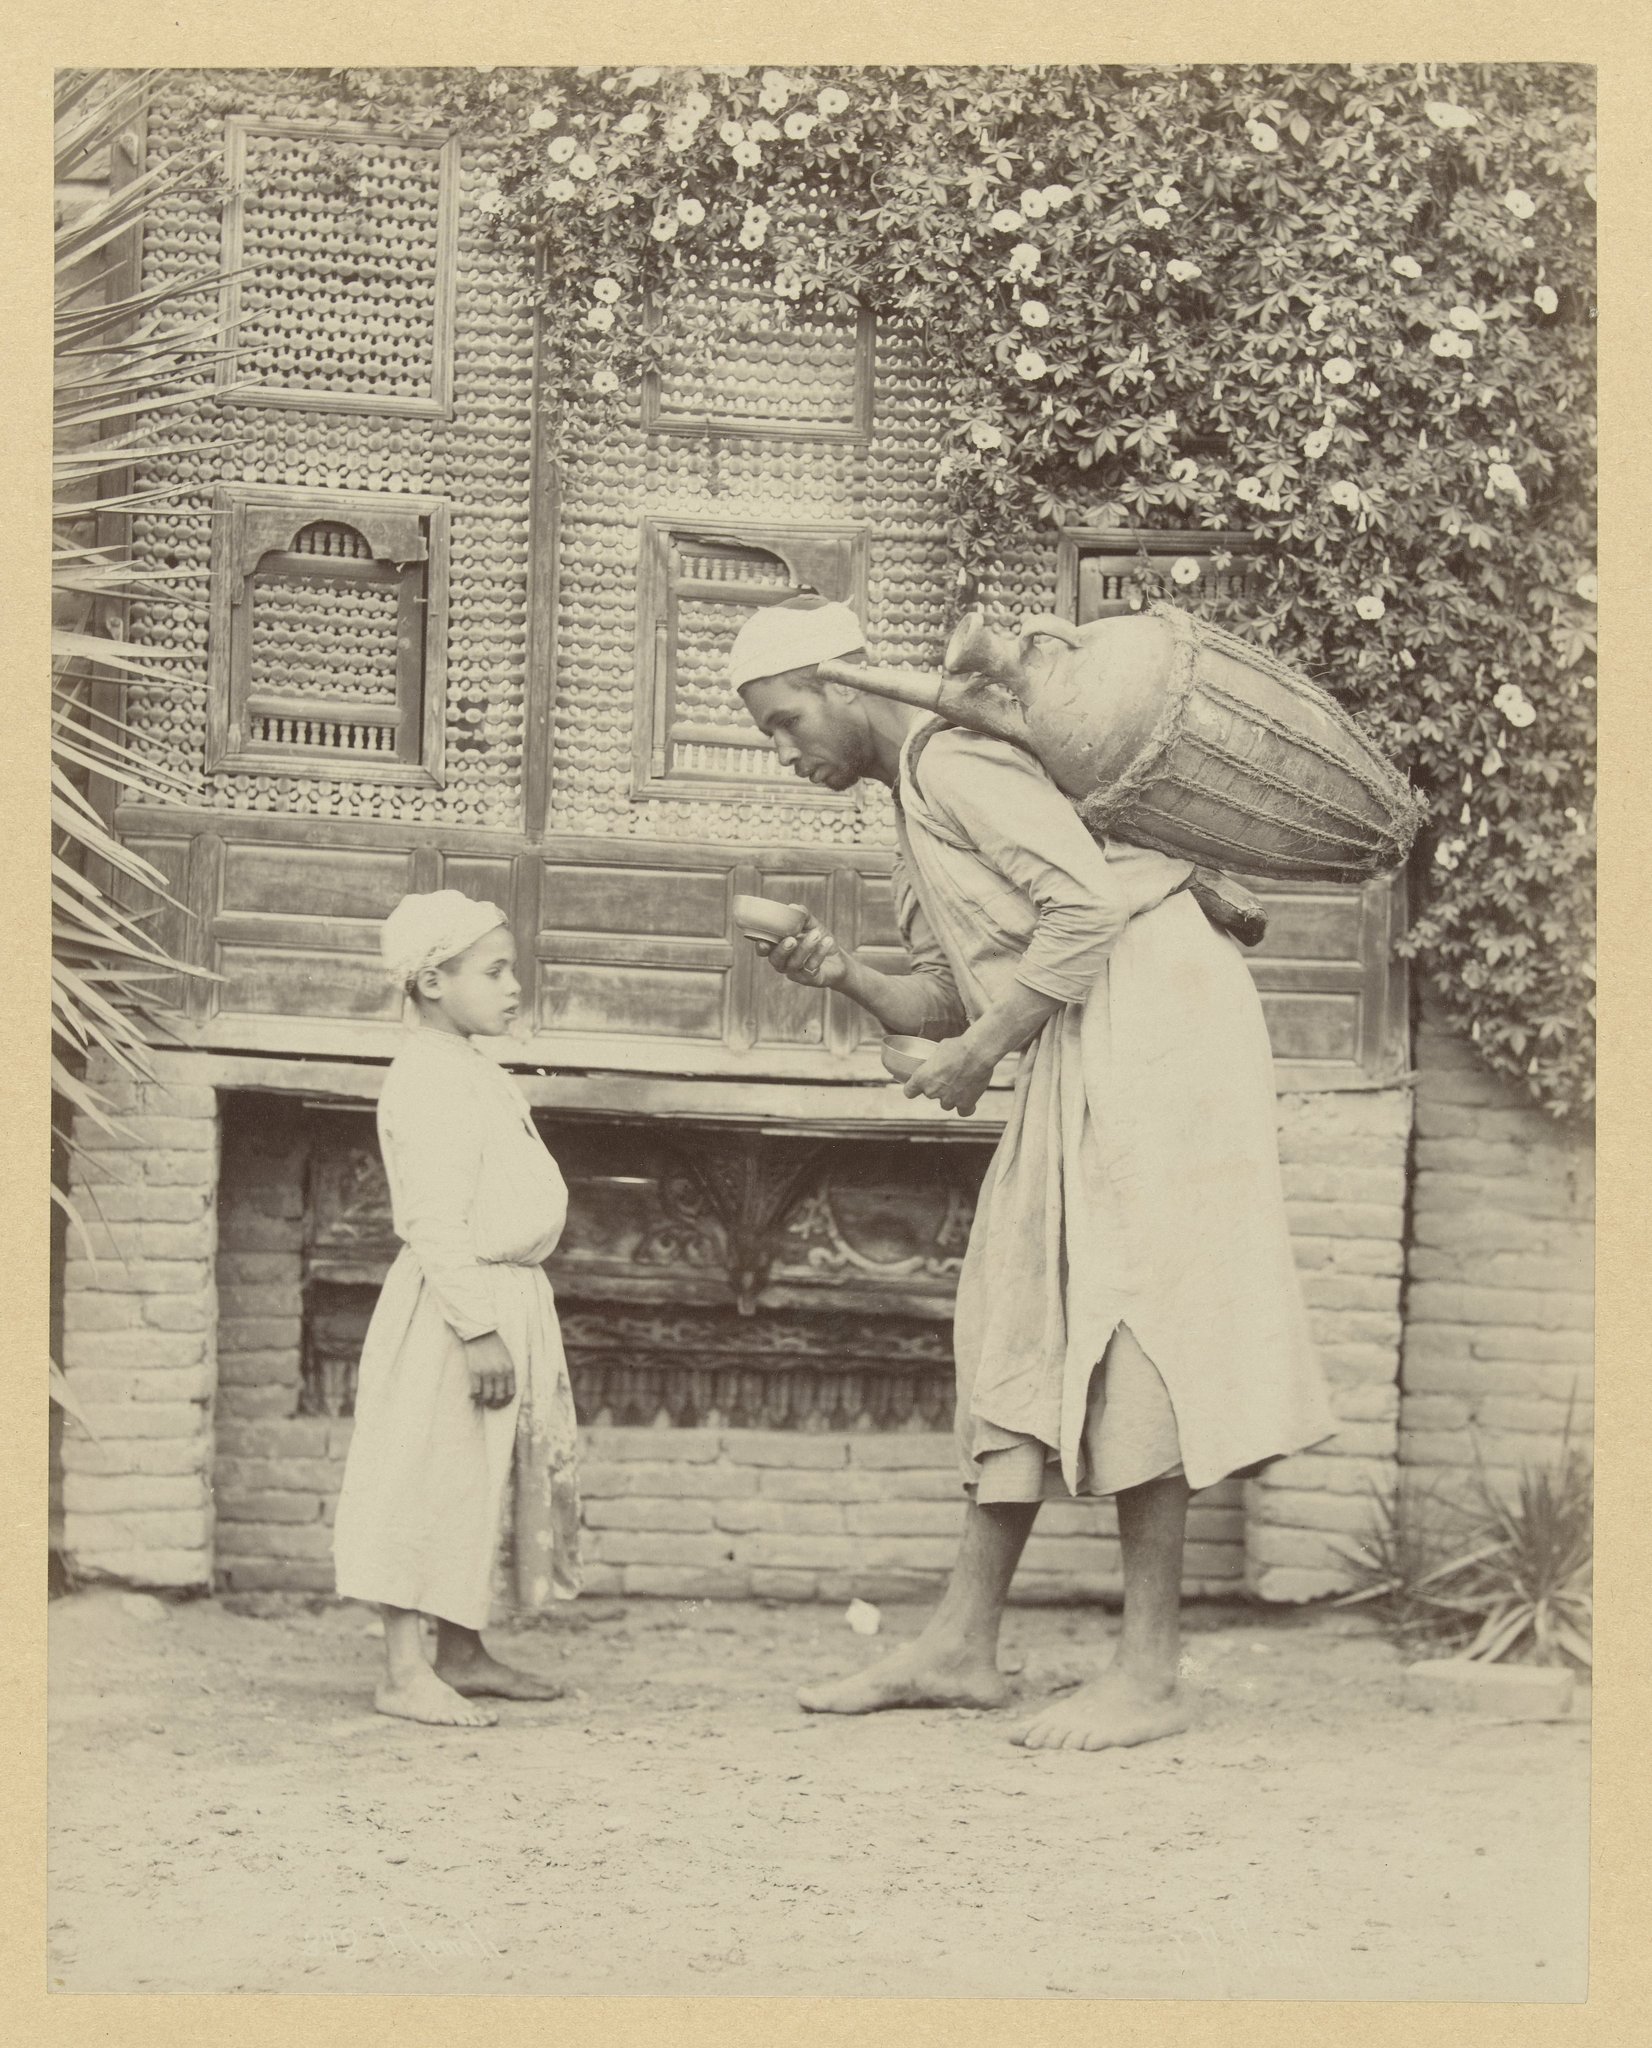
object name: photograph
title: Jongen en een waterdrager, Caïro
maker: jean pascal sébah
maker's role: fotograaf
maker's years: 1872-1947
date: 1888-1895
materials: cardboard, paper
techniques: albumen print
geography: cairo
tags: boy (child between toddler and youth), street-trader, container of ceramics: jar, jug, pot, vase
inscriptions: title: ‘E 16. Waterdrager (Hemeli). Caïro.’, check stamp: ‘Bristol/ L.M.’, number: ‘392’, stamp: ‘Gemeentelijke bibliotheek/ Rotterdam’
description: Onderdeel van een groep door fotograaf Richard Polak op reis verzamelde foto’s. Deze foto is samen met andere op zijn reizen verzamelde foto's tentoongesteld bij de Rotterdamsche Kunstkring (1895), Arti en Amicitiae te Amsterdam (1897-1898?) en Societeit 't Collegie te Kampen (datum vooralsnog onbekend).